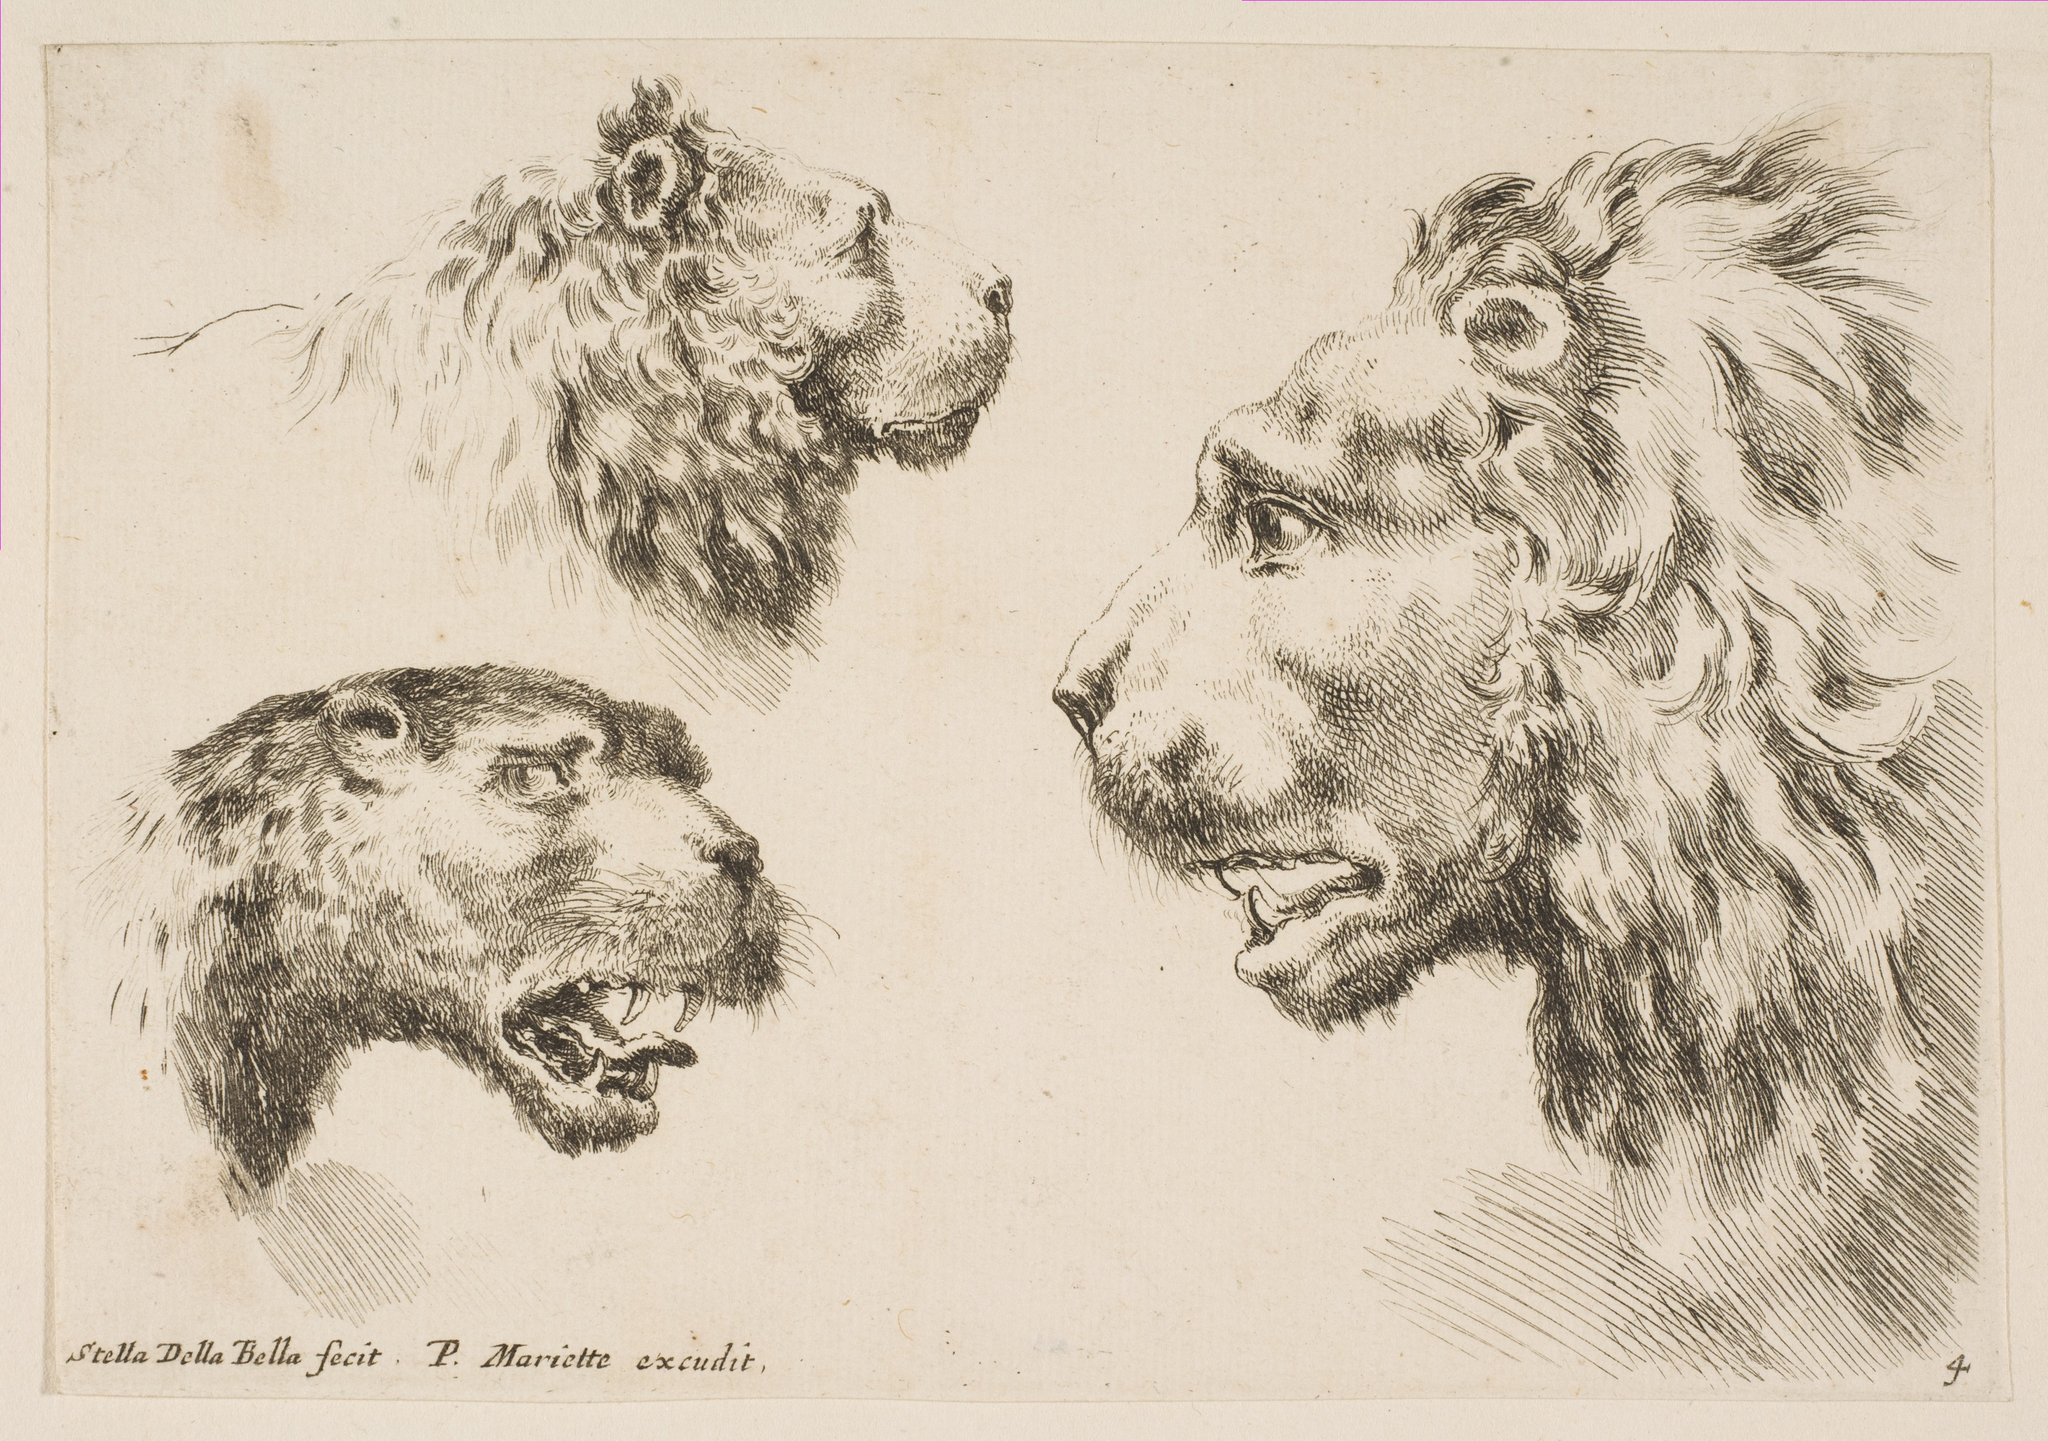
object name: print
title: Heads of Three Lions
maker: stefano della bella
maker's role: artist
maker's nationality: italian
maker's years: 1610-1664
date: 1641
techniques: etching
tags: lions